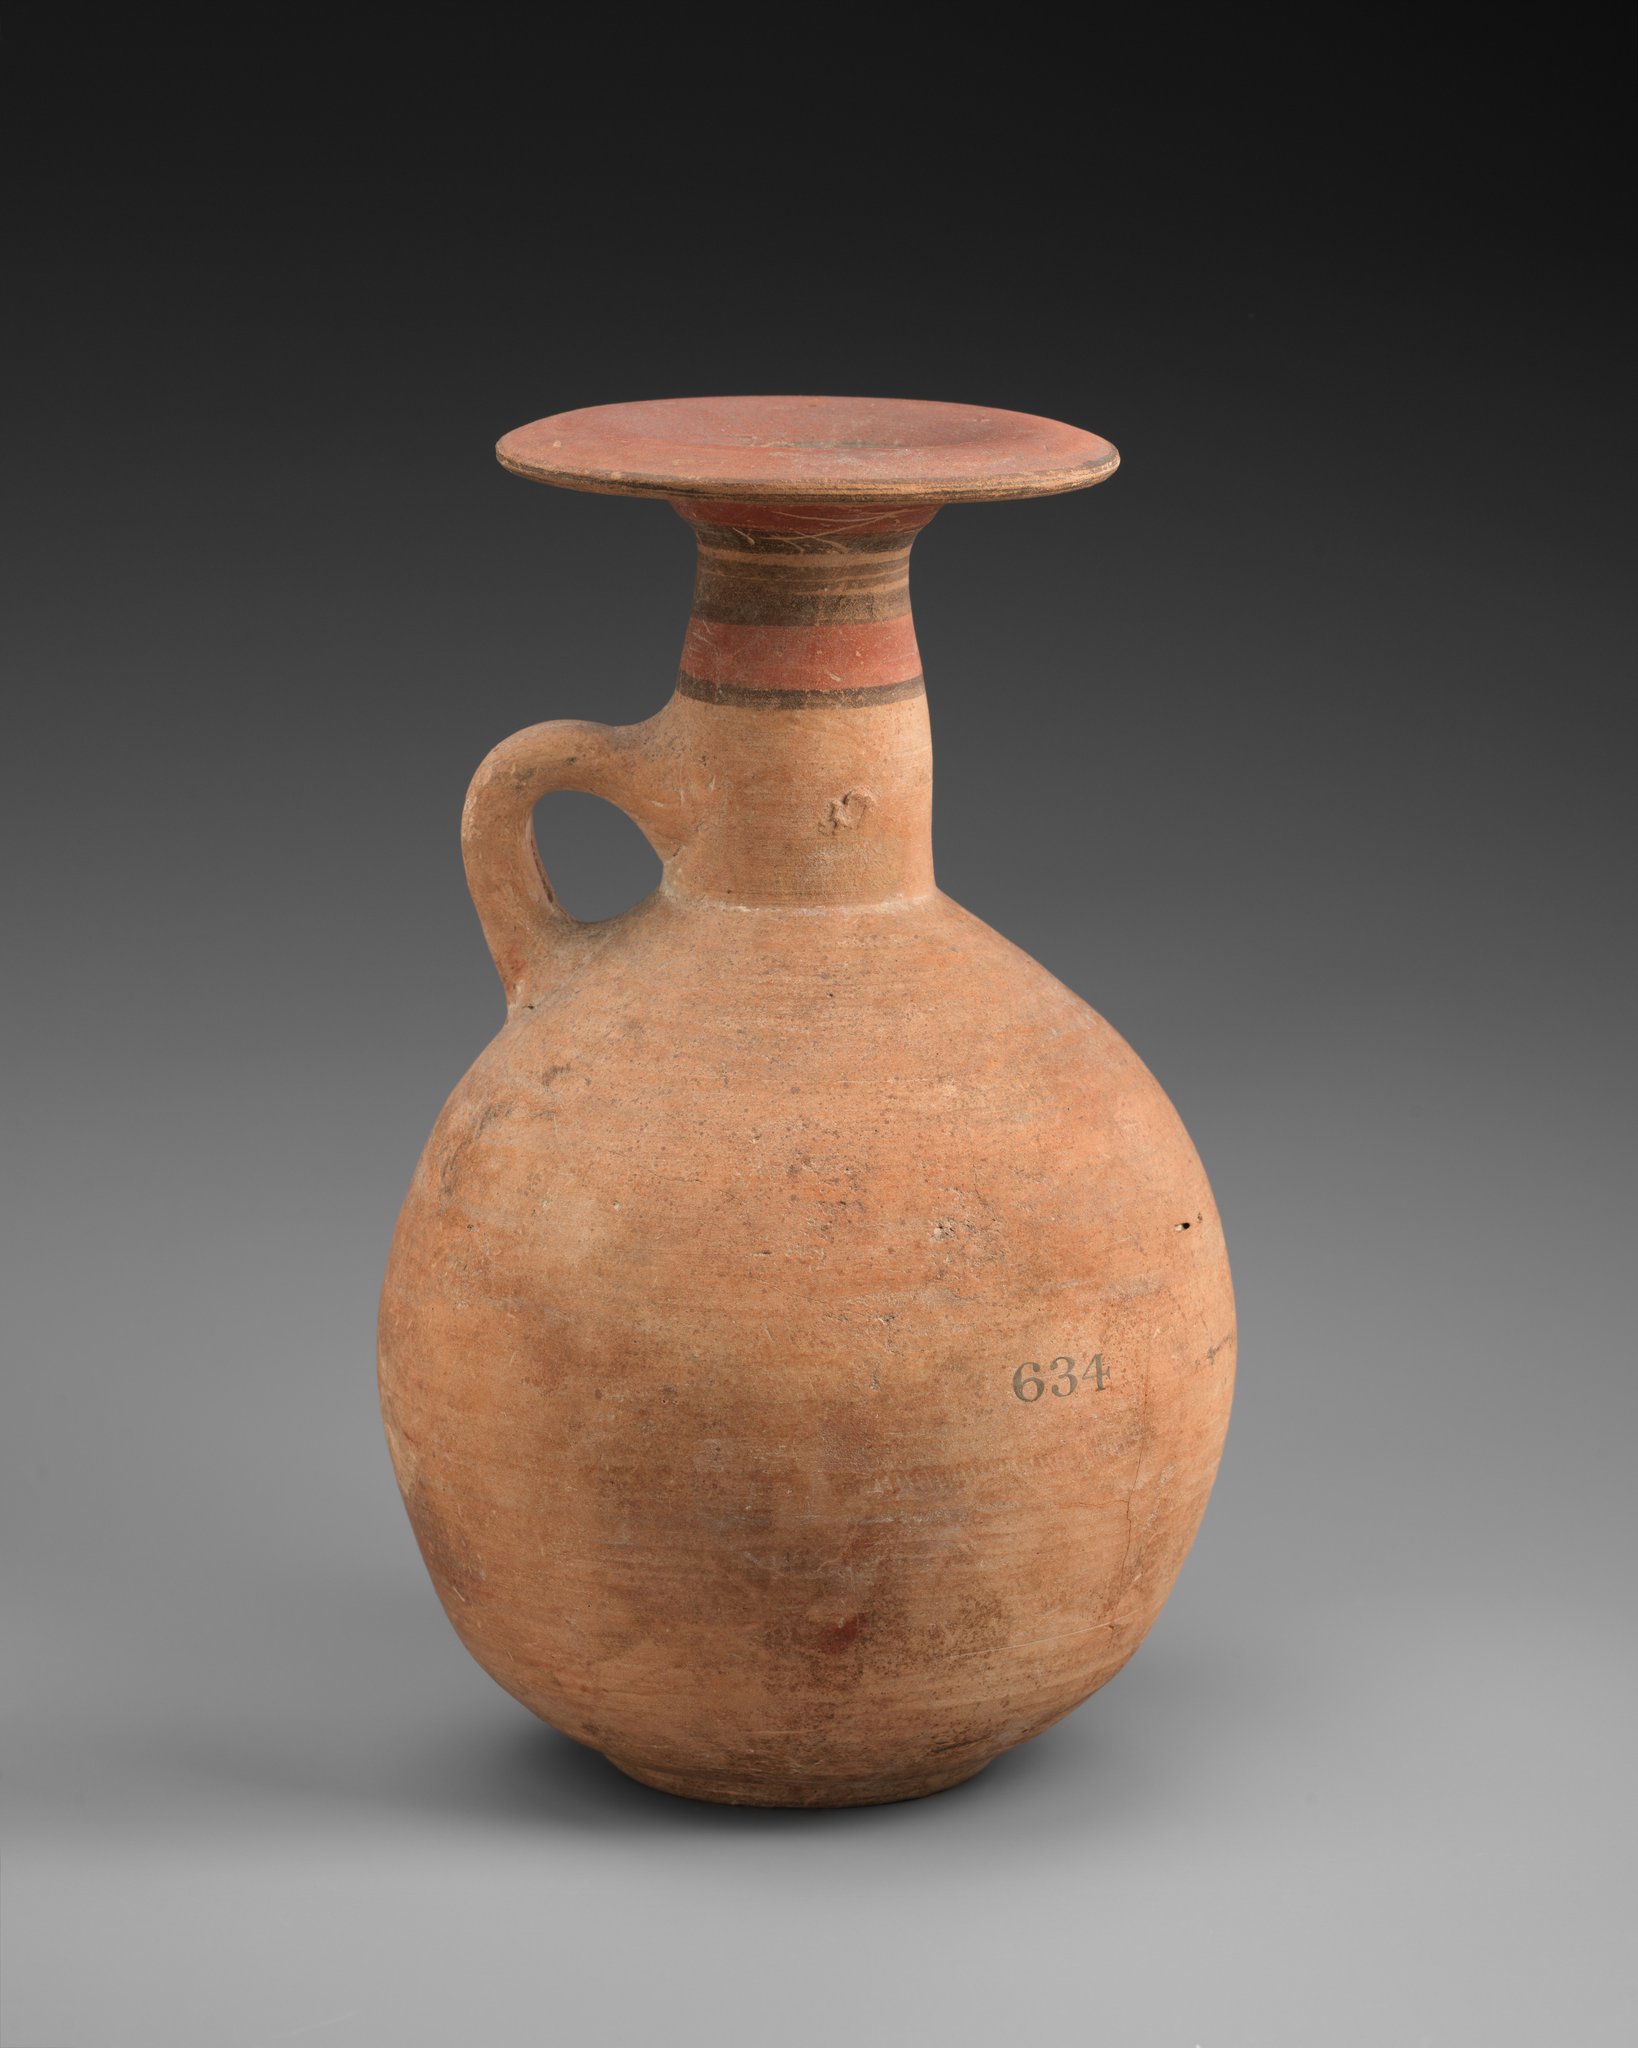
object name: jug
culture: cypriot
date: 600-480 BCE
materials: terracotta